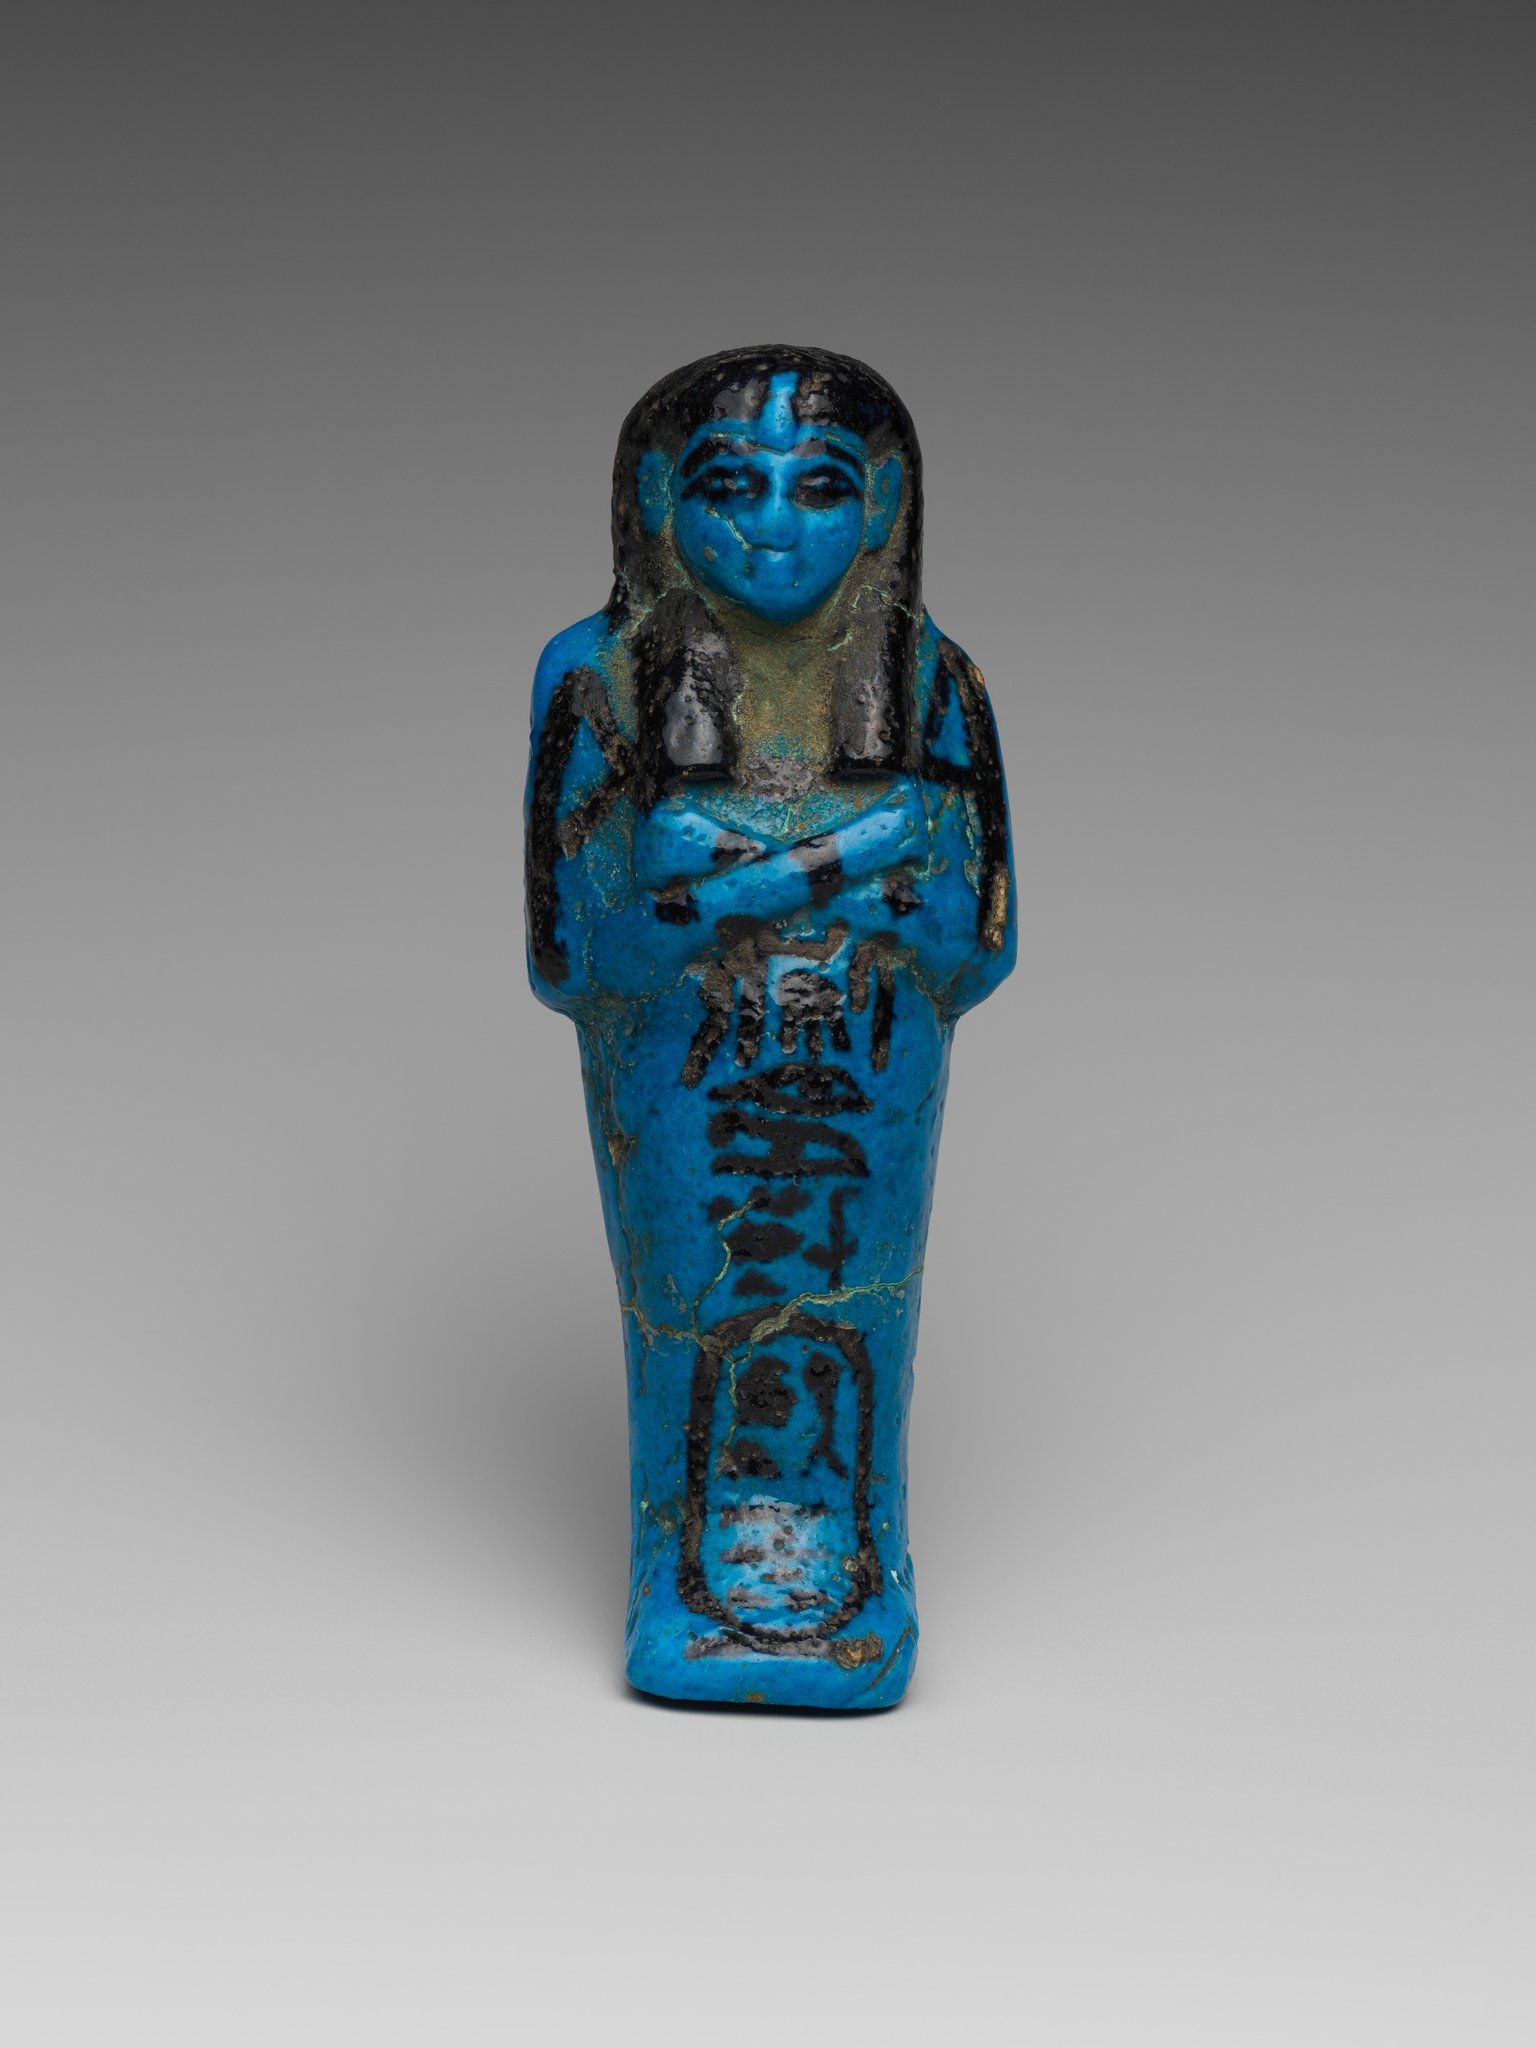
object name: shabti, queen henettawy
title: Shabti of the Adoratrice of Hathor Henettawy, wife of Painedjem I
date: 1064-1055 BCE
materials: faience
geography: upper egypt, thebes